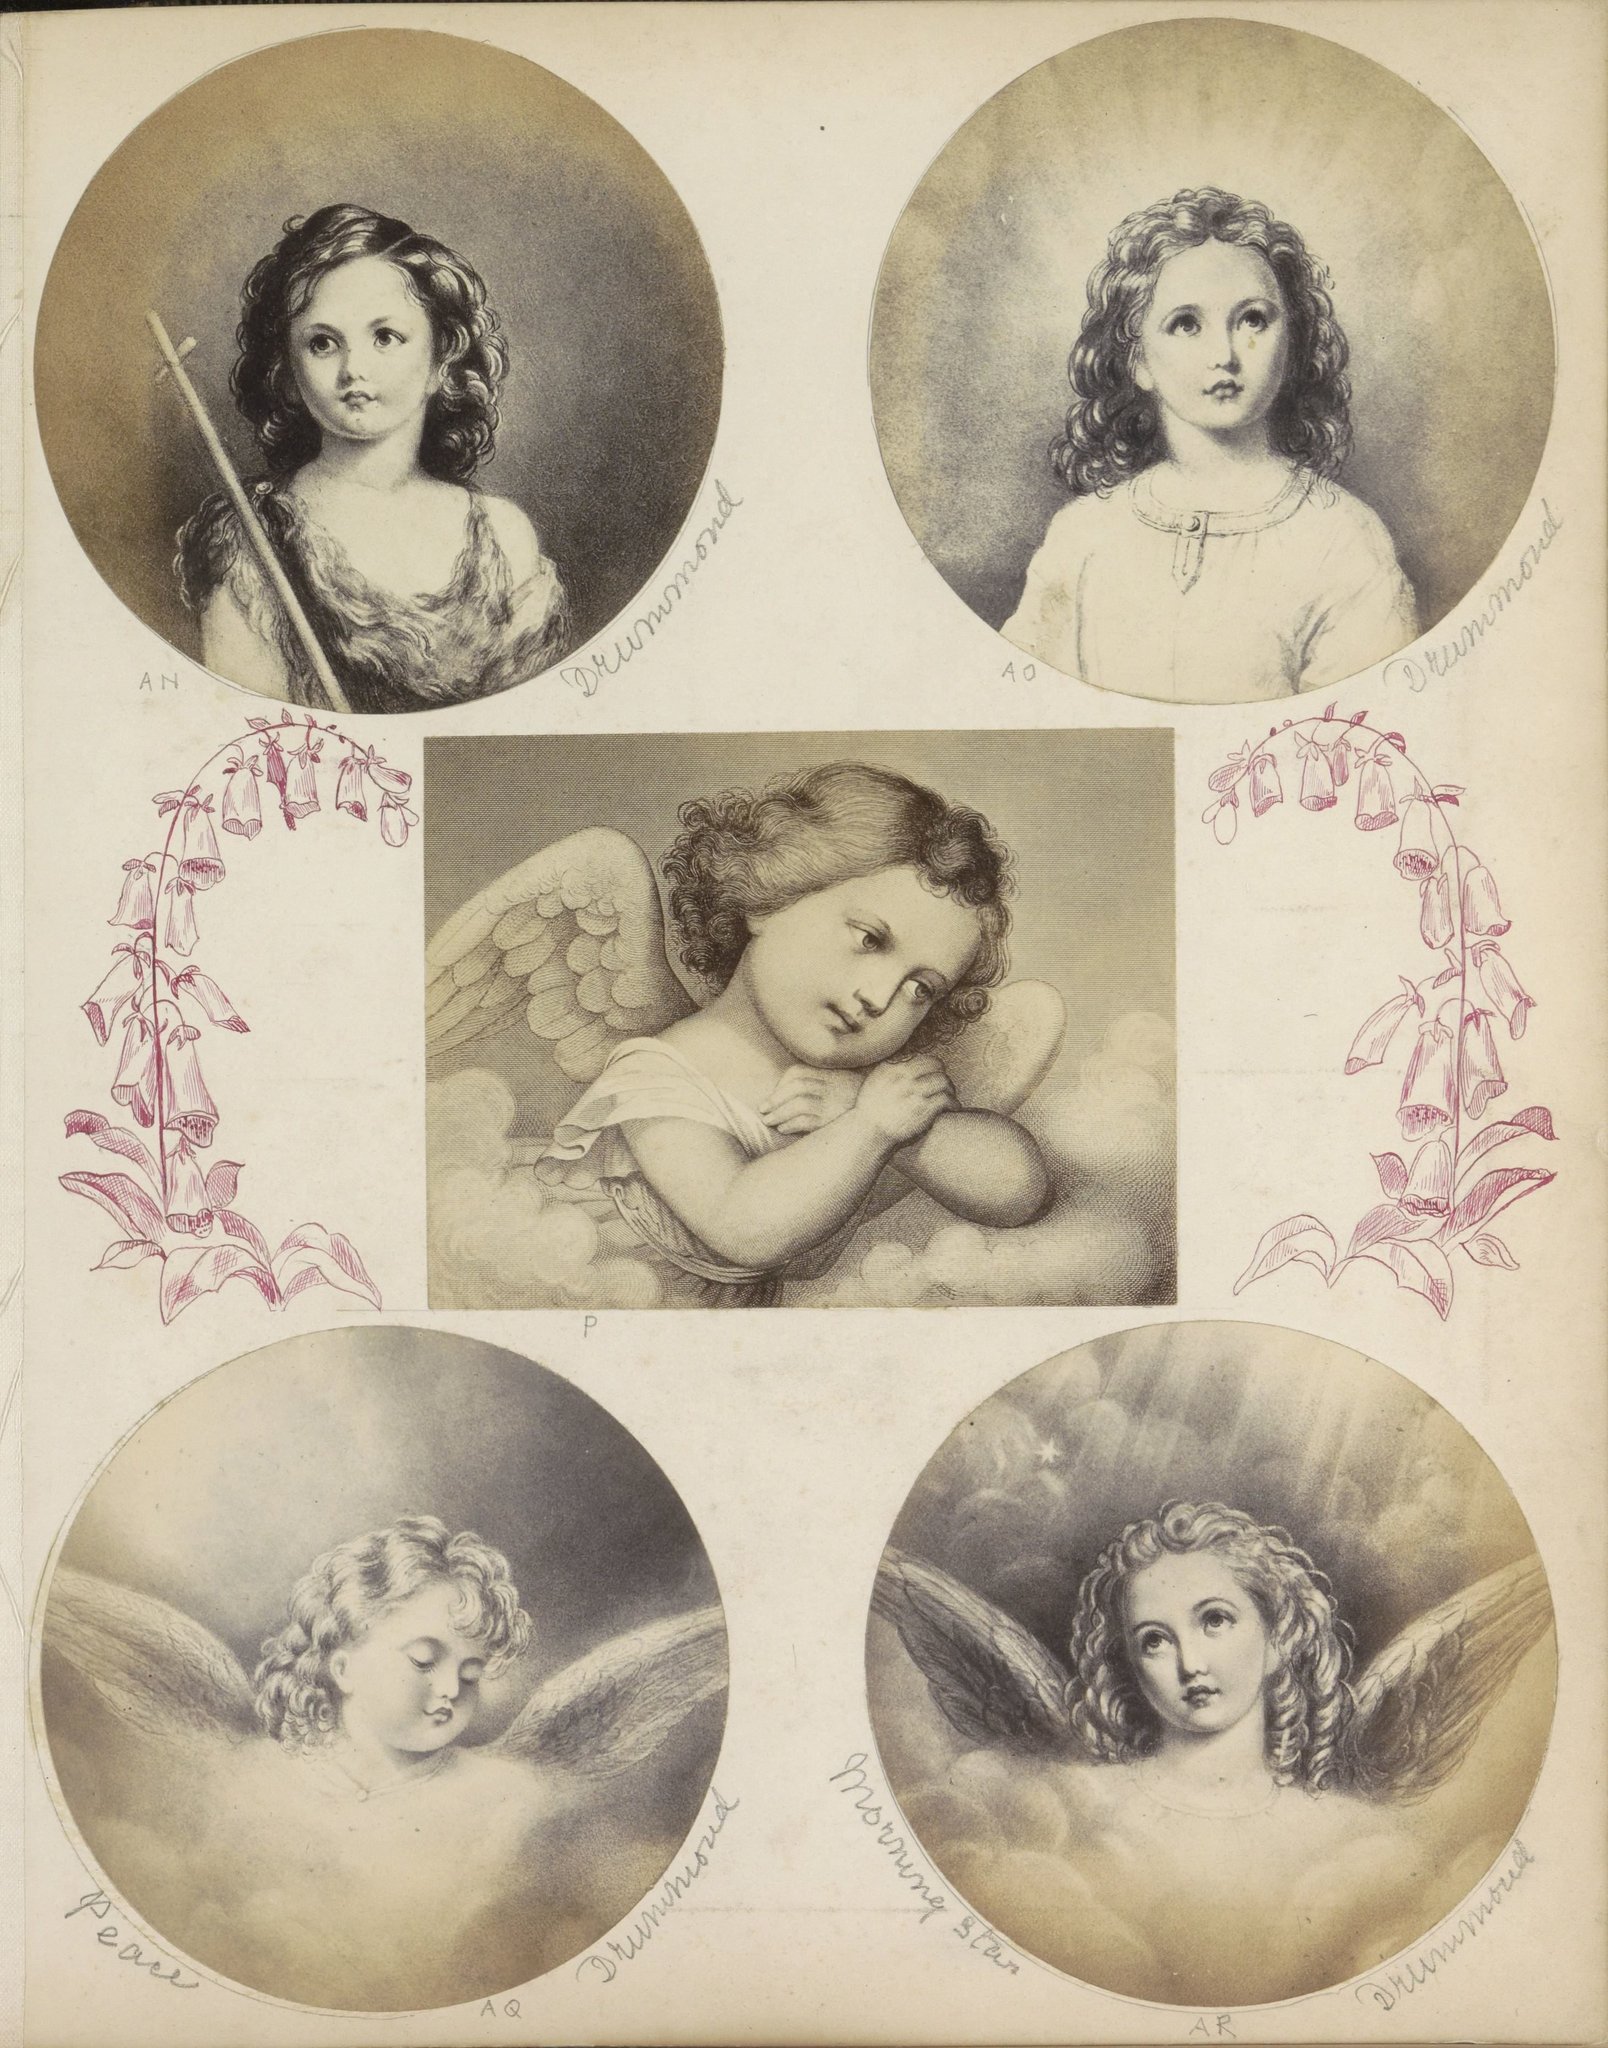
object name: photograph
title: Fotoreproductie van (vermoedelijk) een tekening van een engel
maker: Anonymous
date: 1850-1870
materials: paper, photographic support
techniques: albumen print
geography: england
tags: angel(s) represented as child(ren)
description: Onderdeel van Album met foto's van bezienswaardigheden en landschappen in Engeland en van kunst.